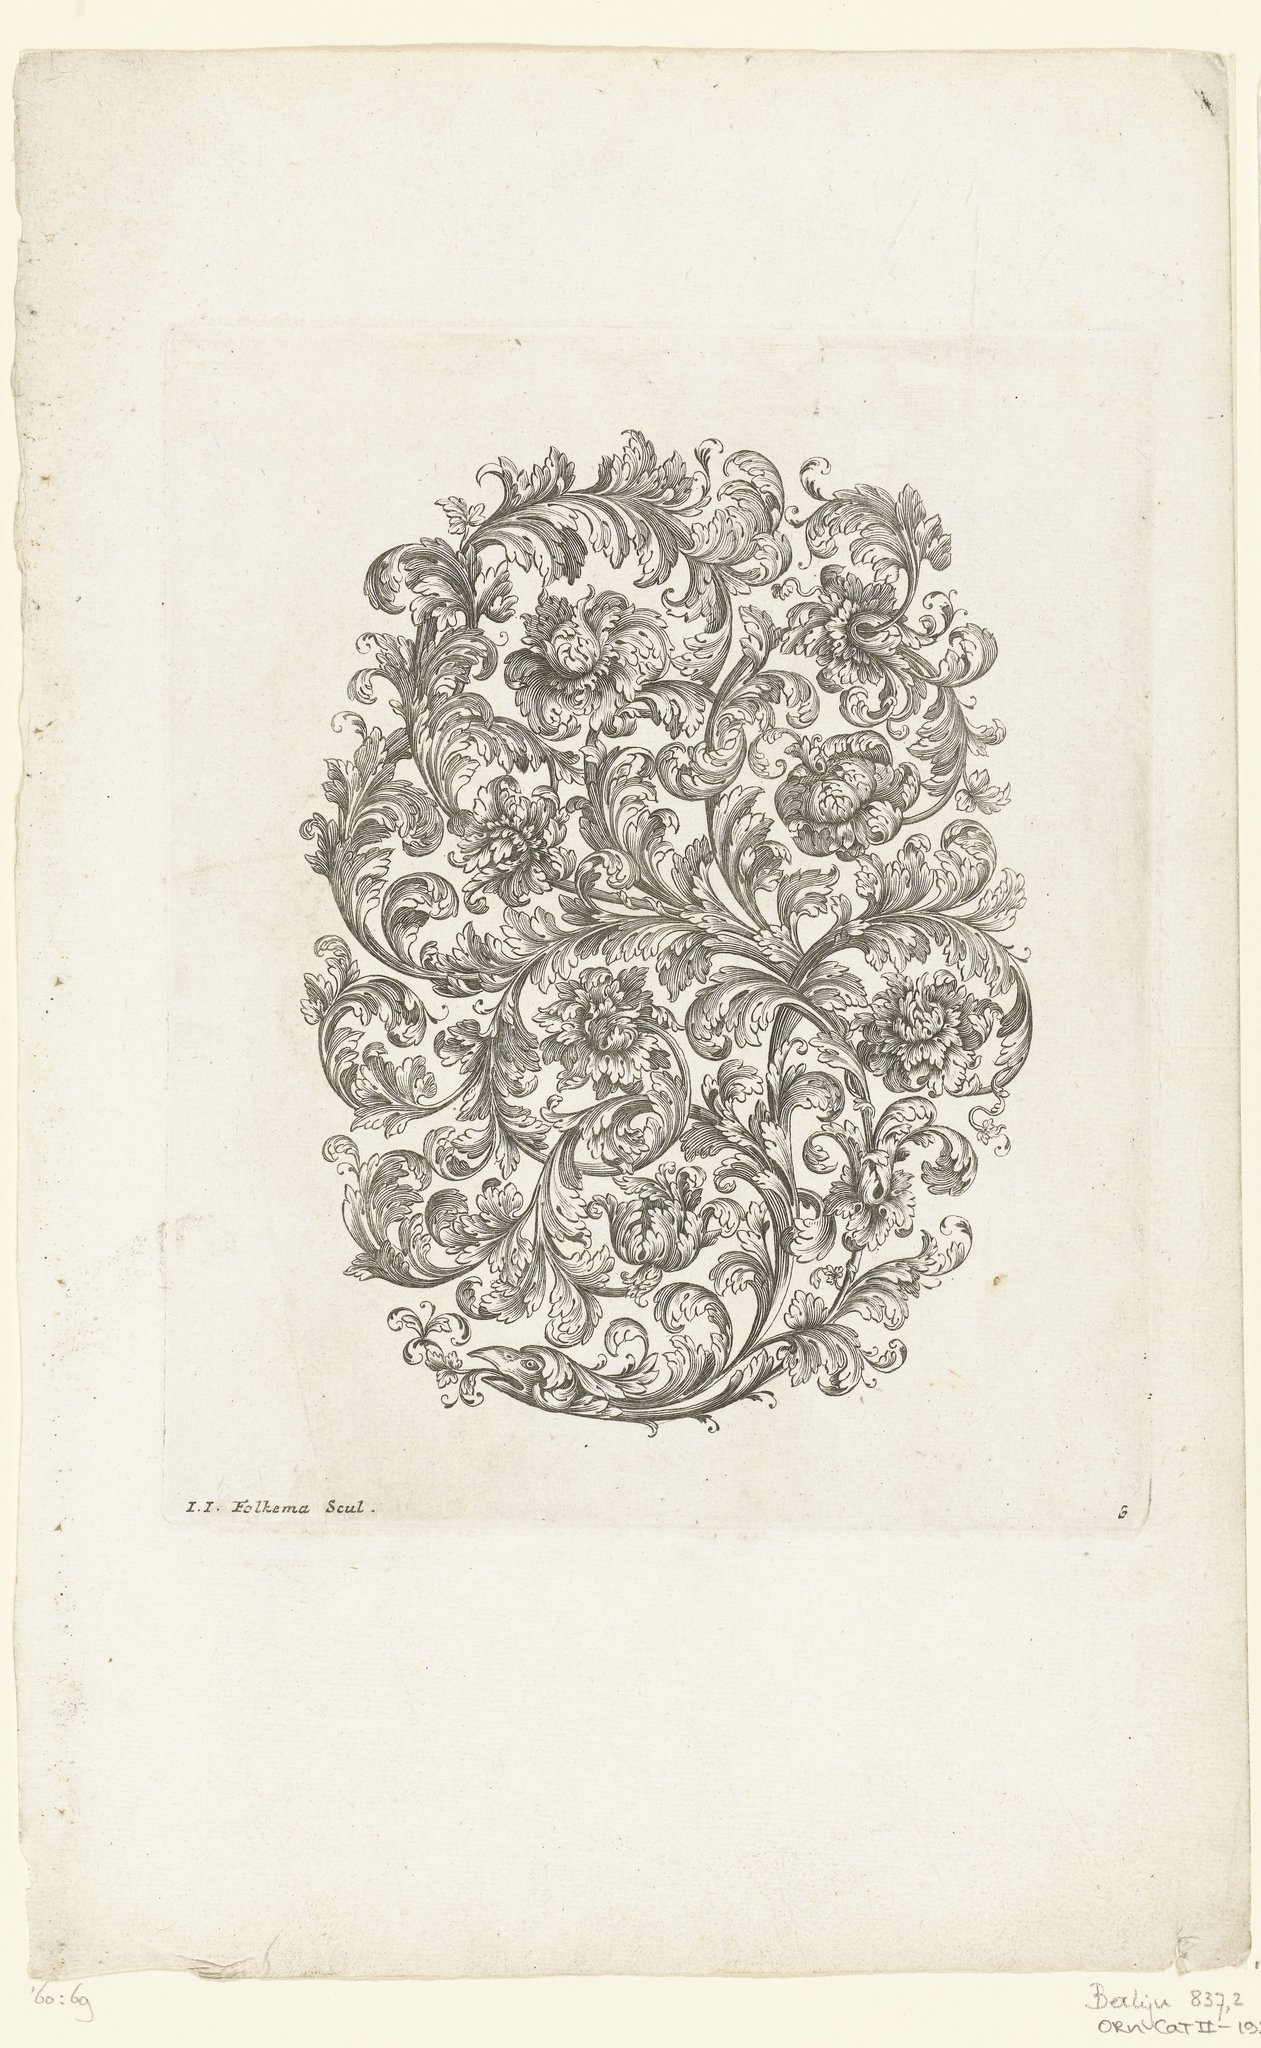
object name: print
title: Liure de Feuillages et d'Ouvrages d'Orfevrerie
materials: paper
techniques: engraving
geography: amsterdam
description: De bladranken lopen onderaan uit in de kop van een vogel.